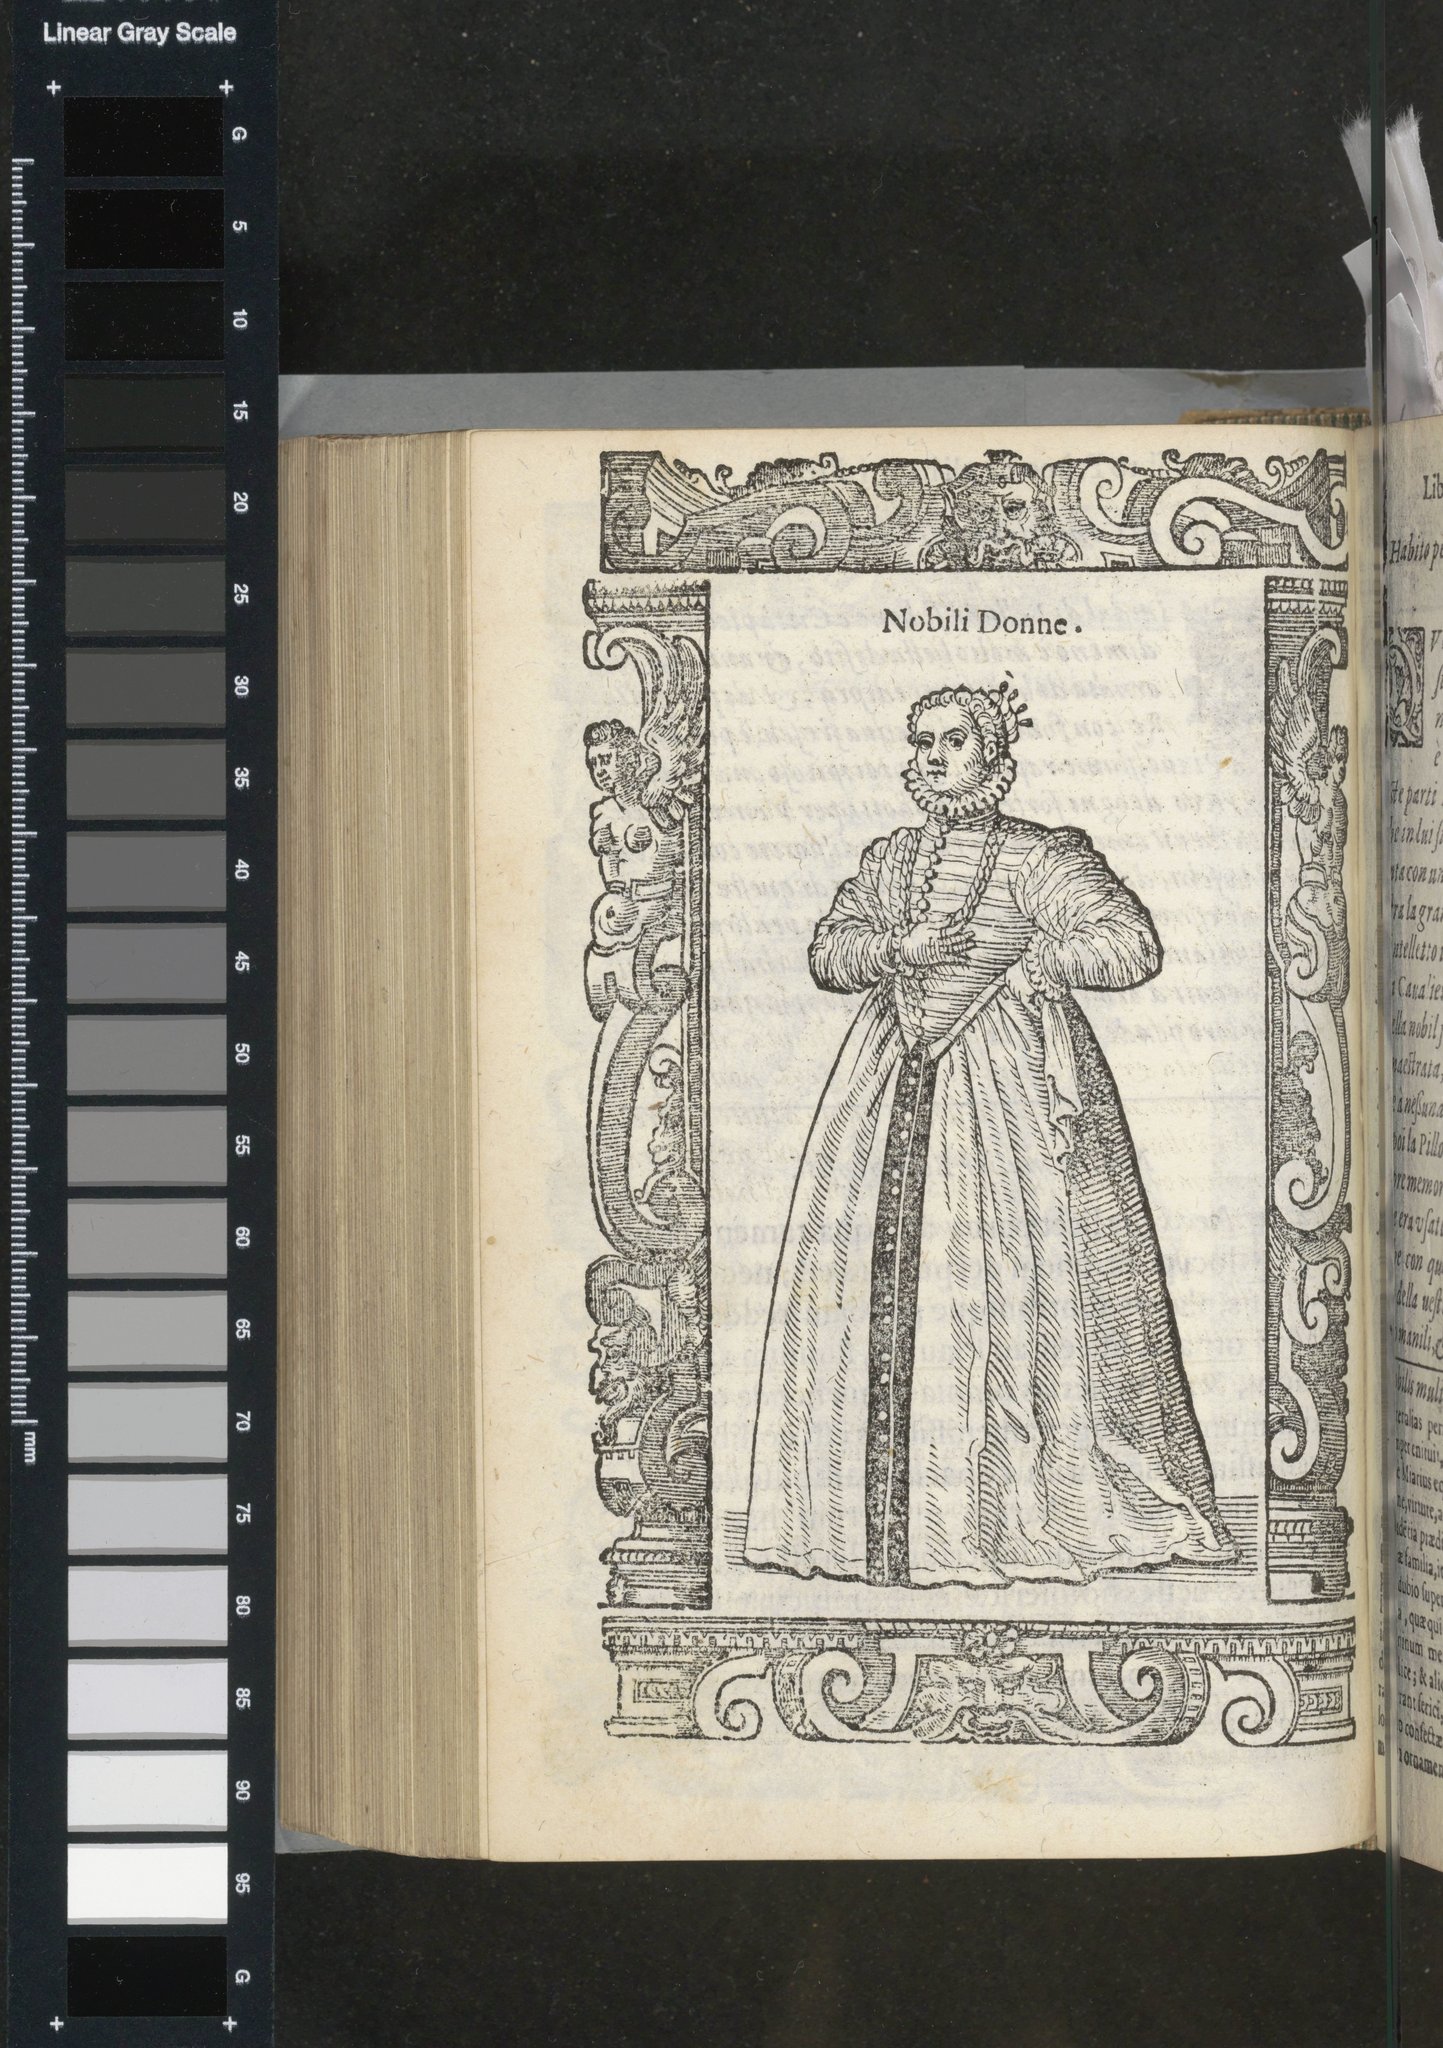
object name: costume print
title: Nobile donne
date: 1598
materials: paper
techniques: woodcut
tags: fashion plates